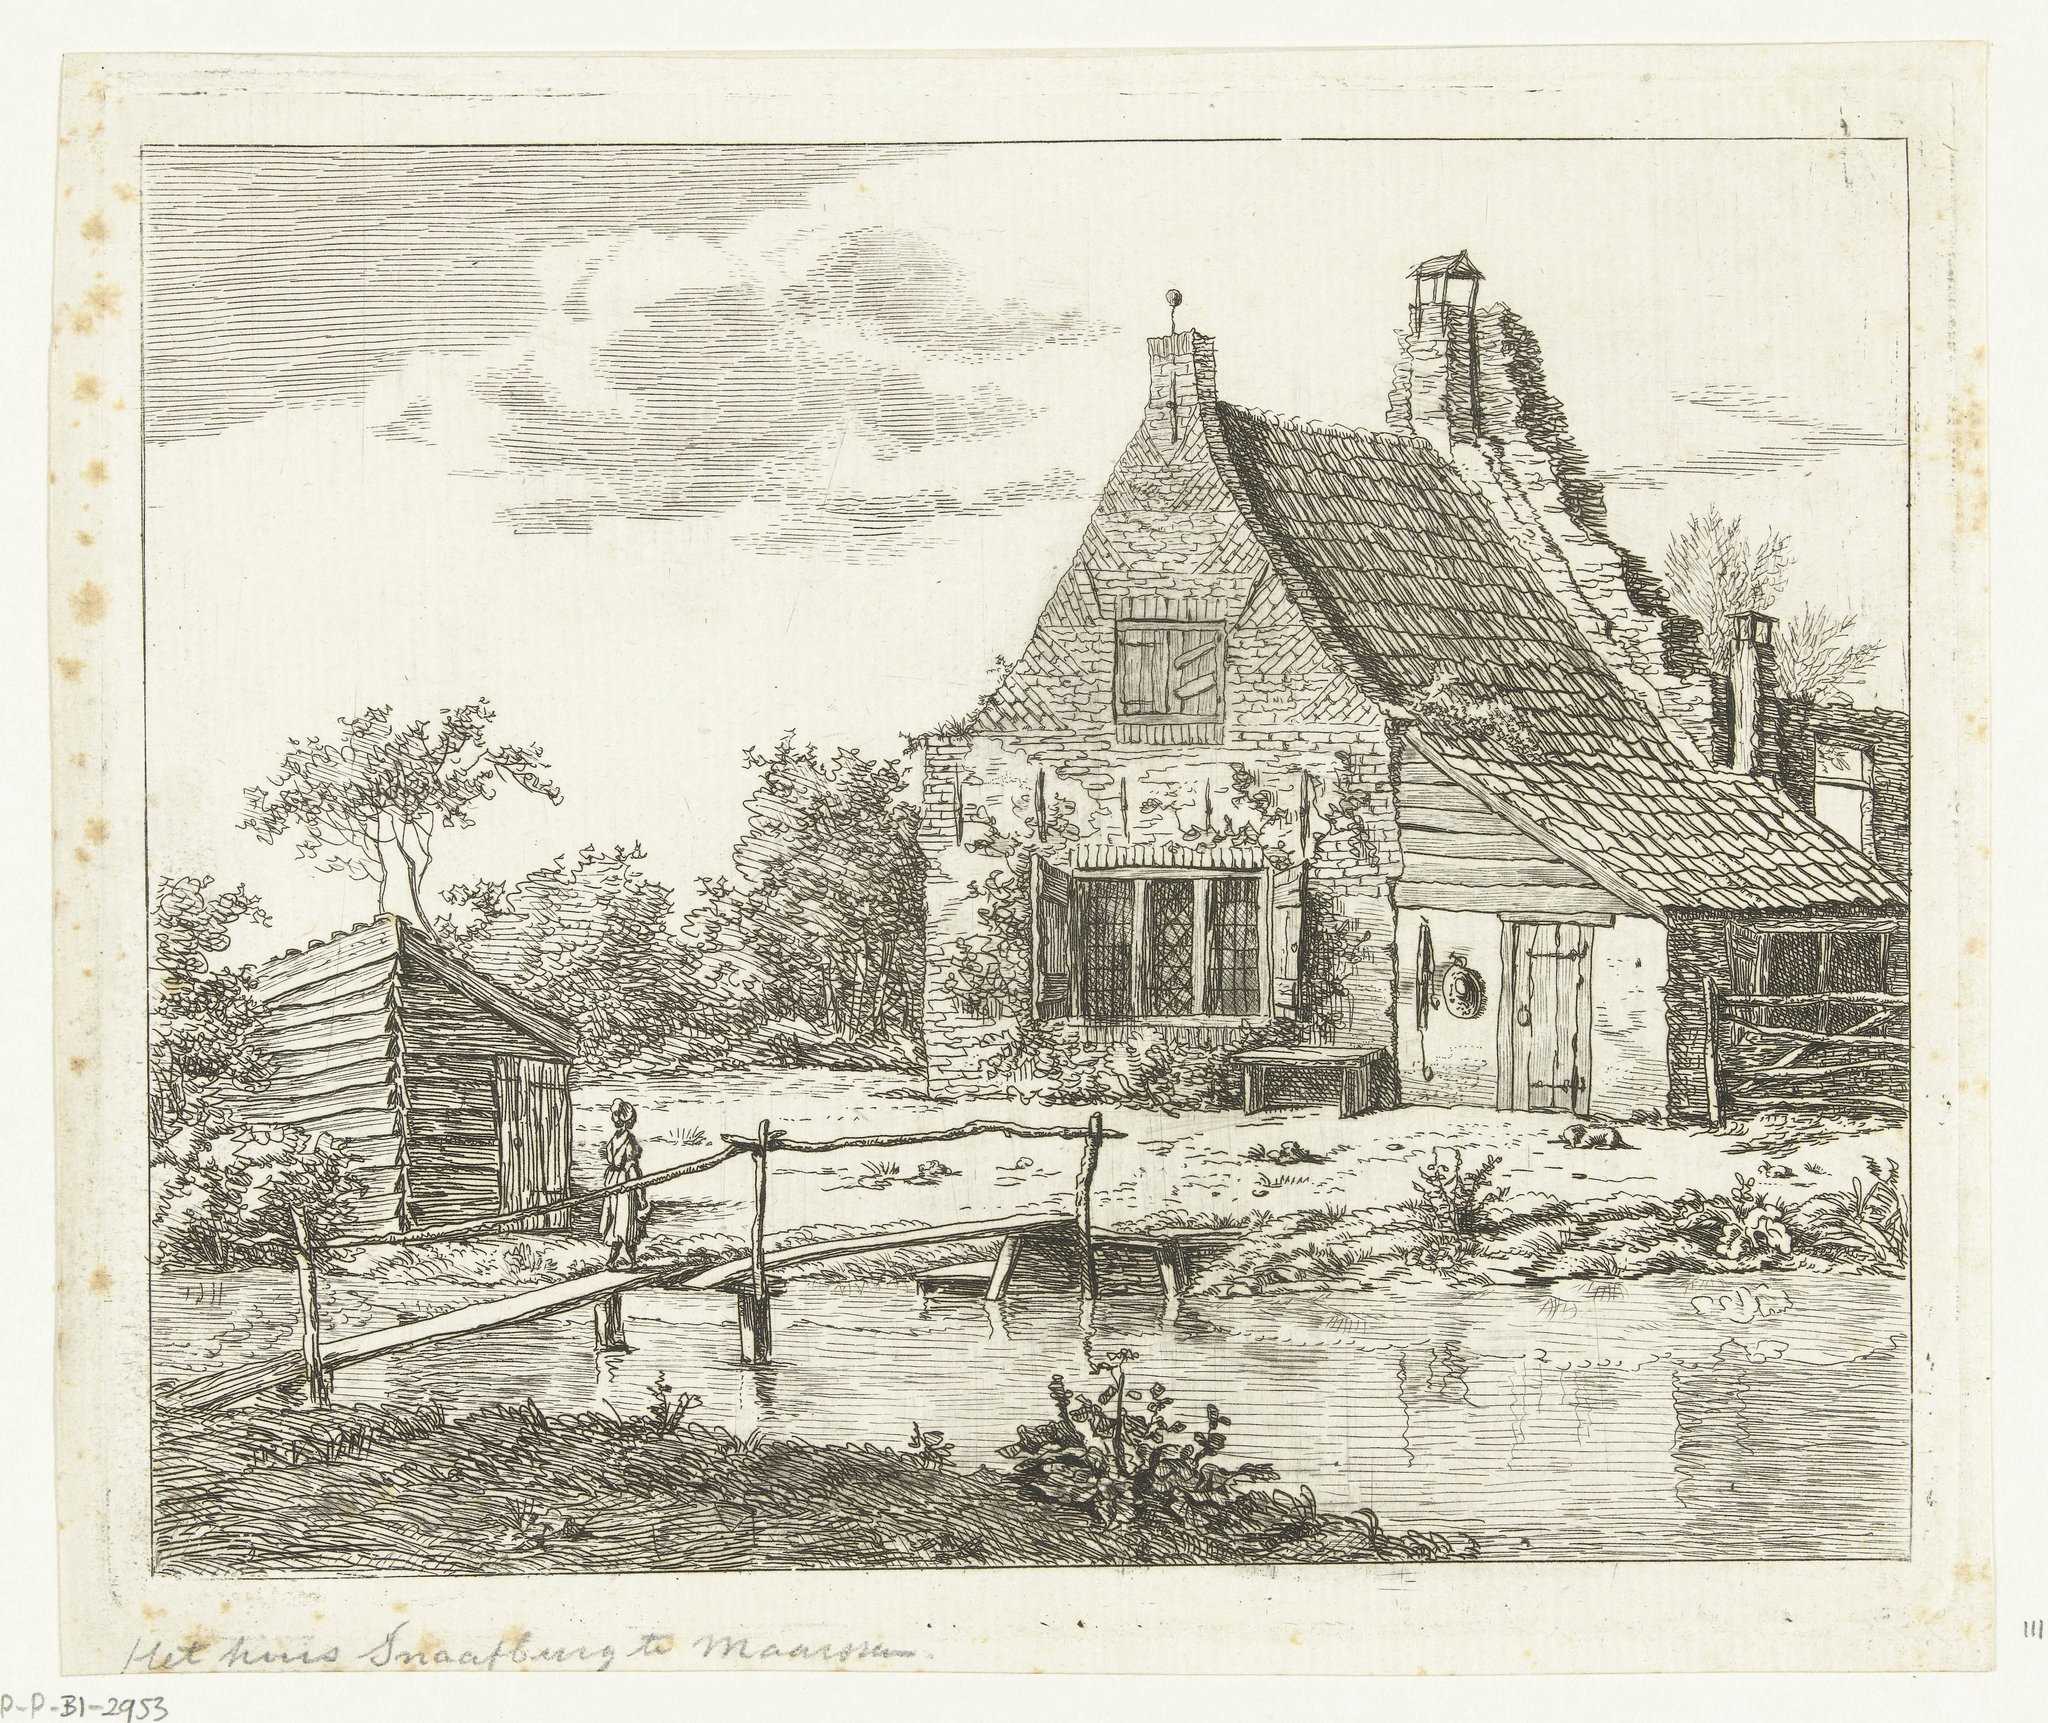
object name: print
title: Huis Snaatburg te Maarssen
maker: anthonie van den bos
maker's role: draughtsman, print maker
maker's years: 1763-1838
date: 1802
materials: paper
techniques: etching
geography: netherlands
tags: ruin of a dwelling, house, castle, etc.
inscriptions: collector's mark: Lugt 2228